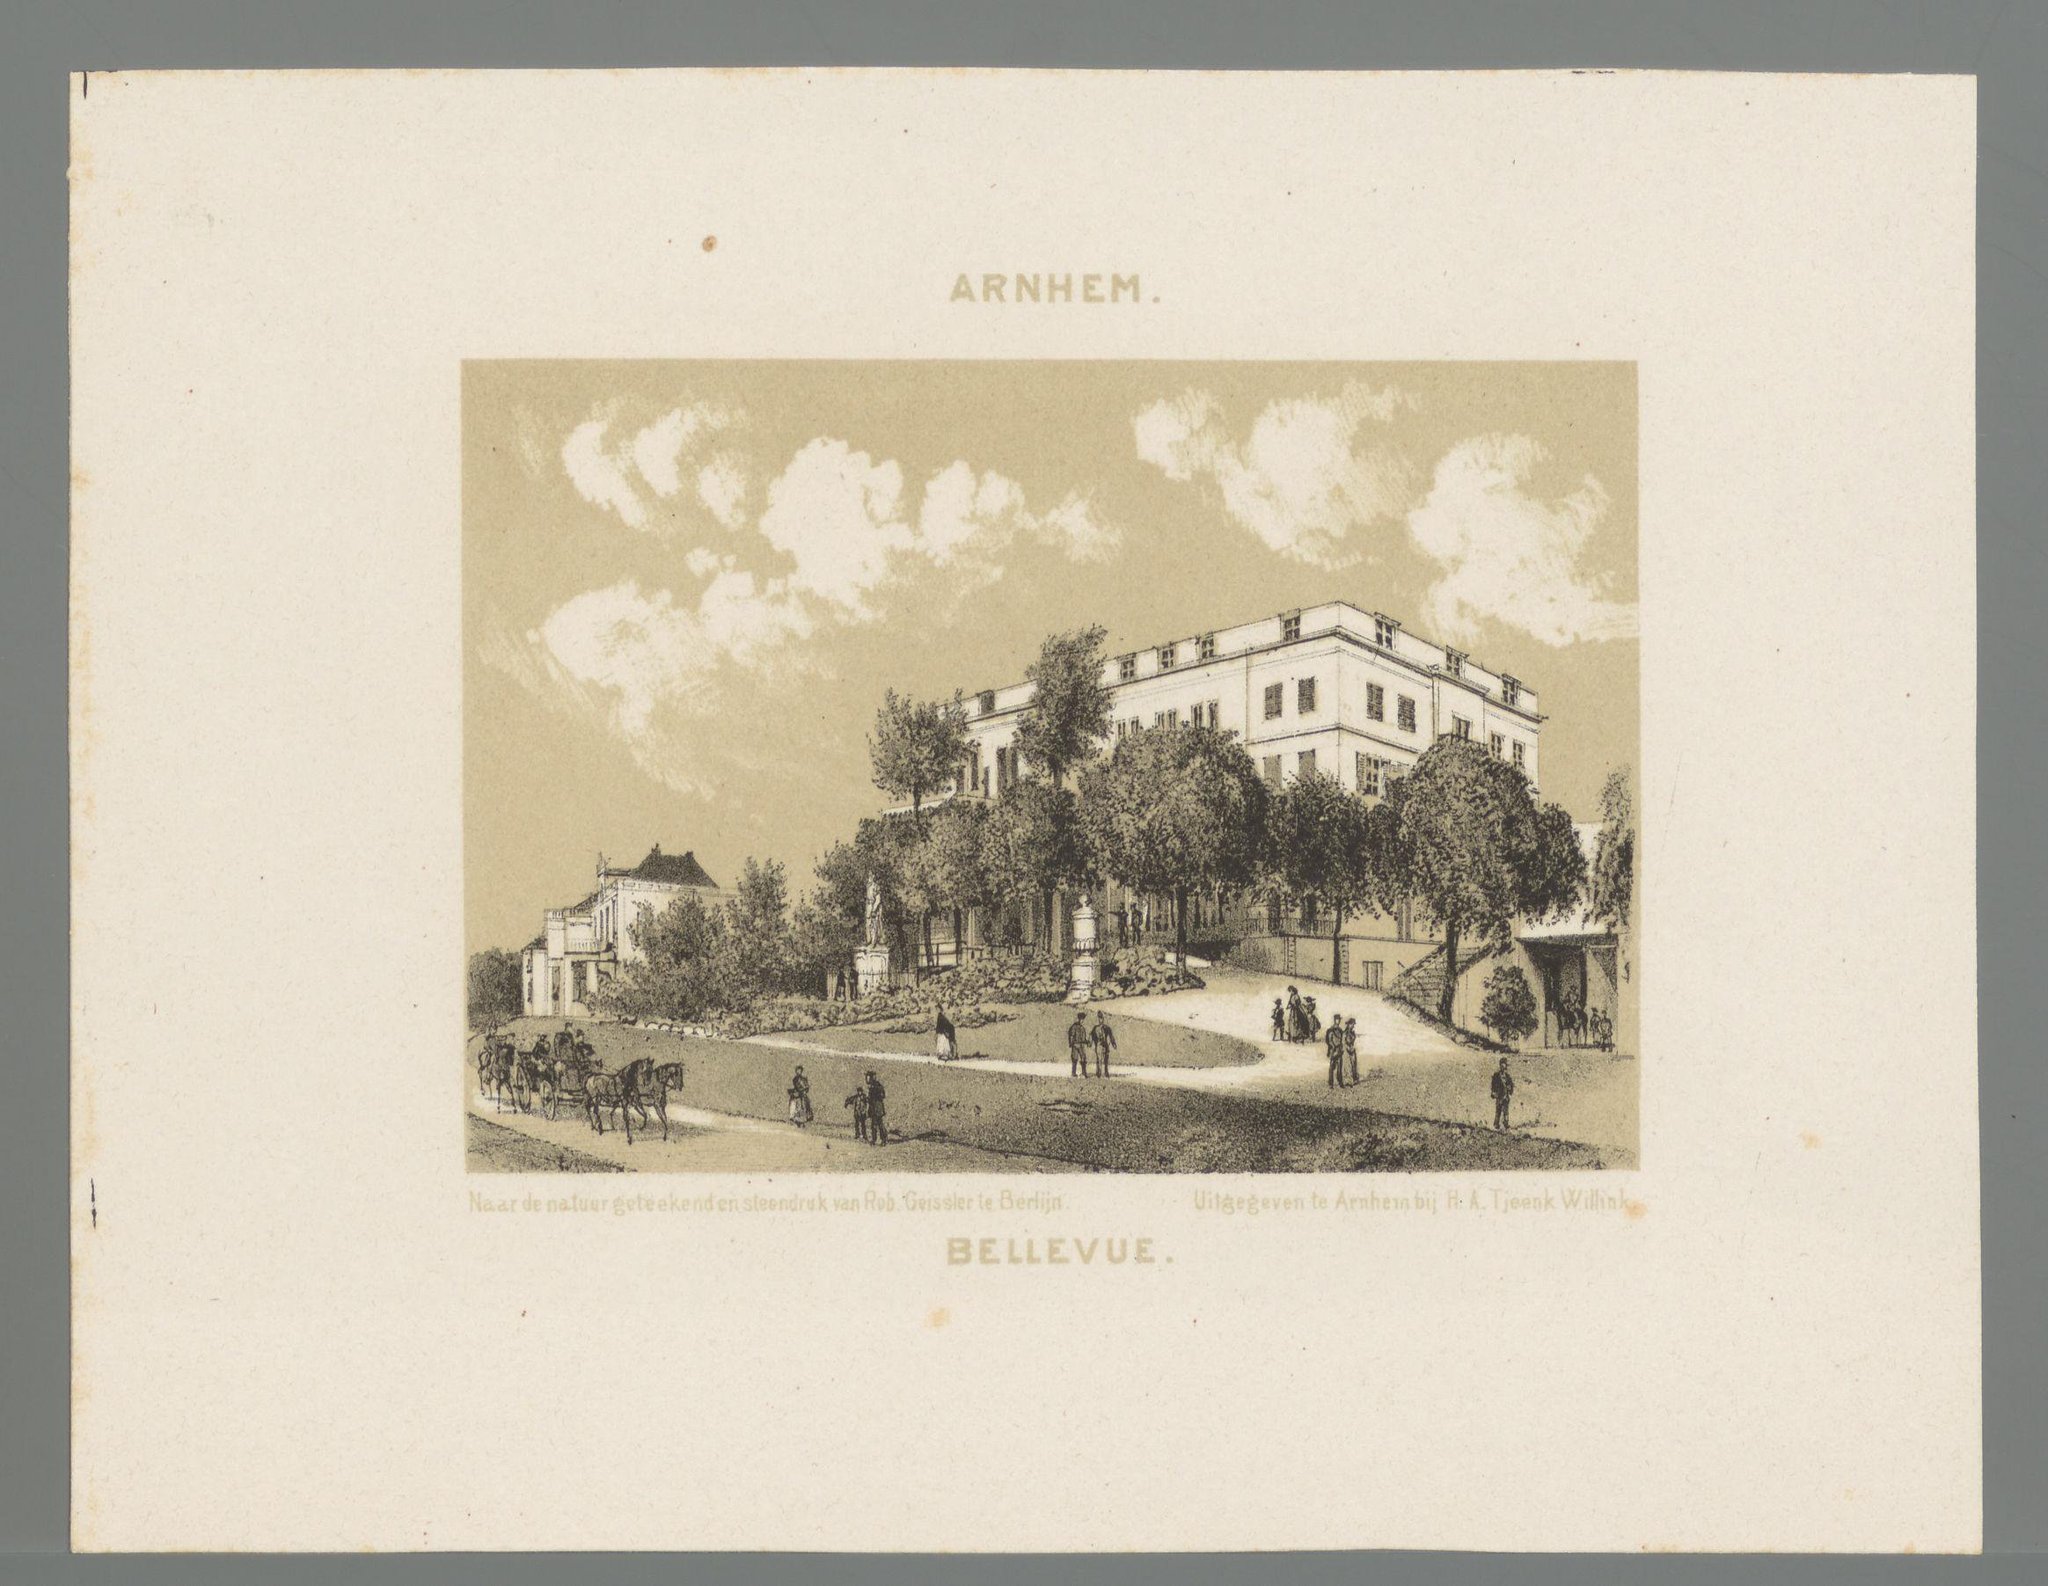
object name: print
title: Bellevue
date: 1865-1875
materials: paper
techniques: tone lithography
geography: berlin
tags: civic architecture; edifices; dwellings, hotel, hostelry, inn, arnhem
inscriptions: collector's mark: Lugt 2228